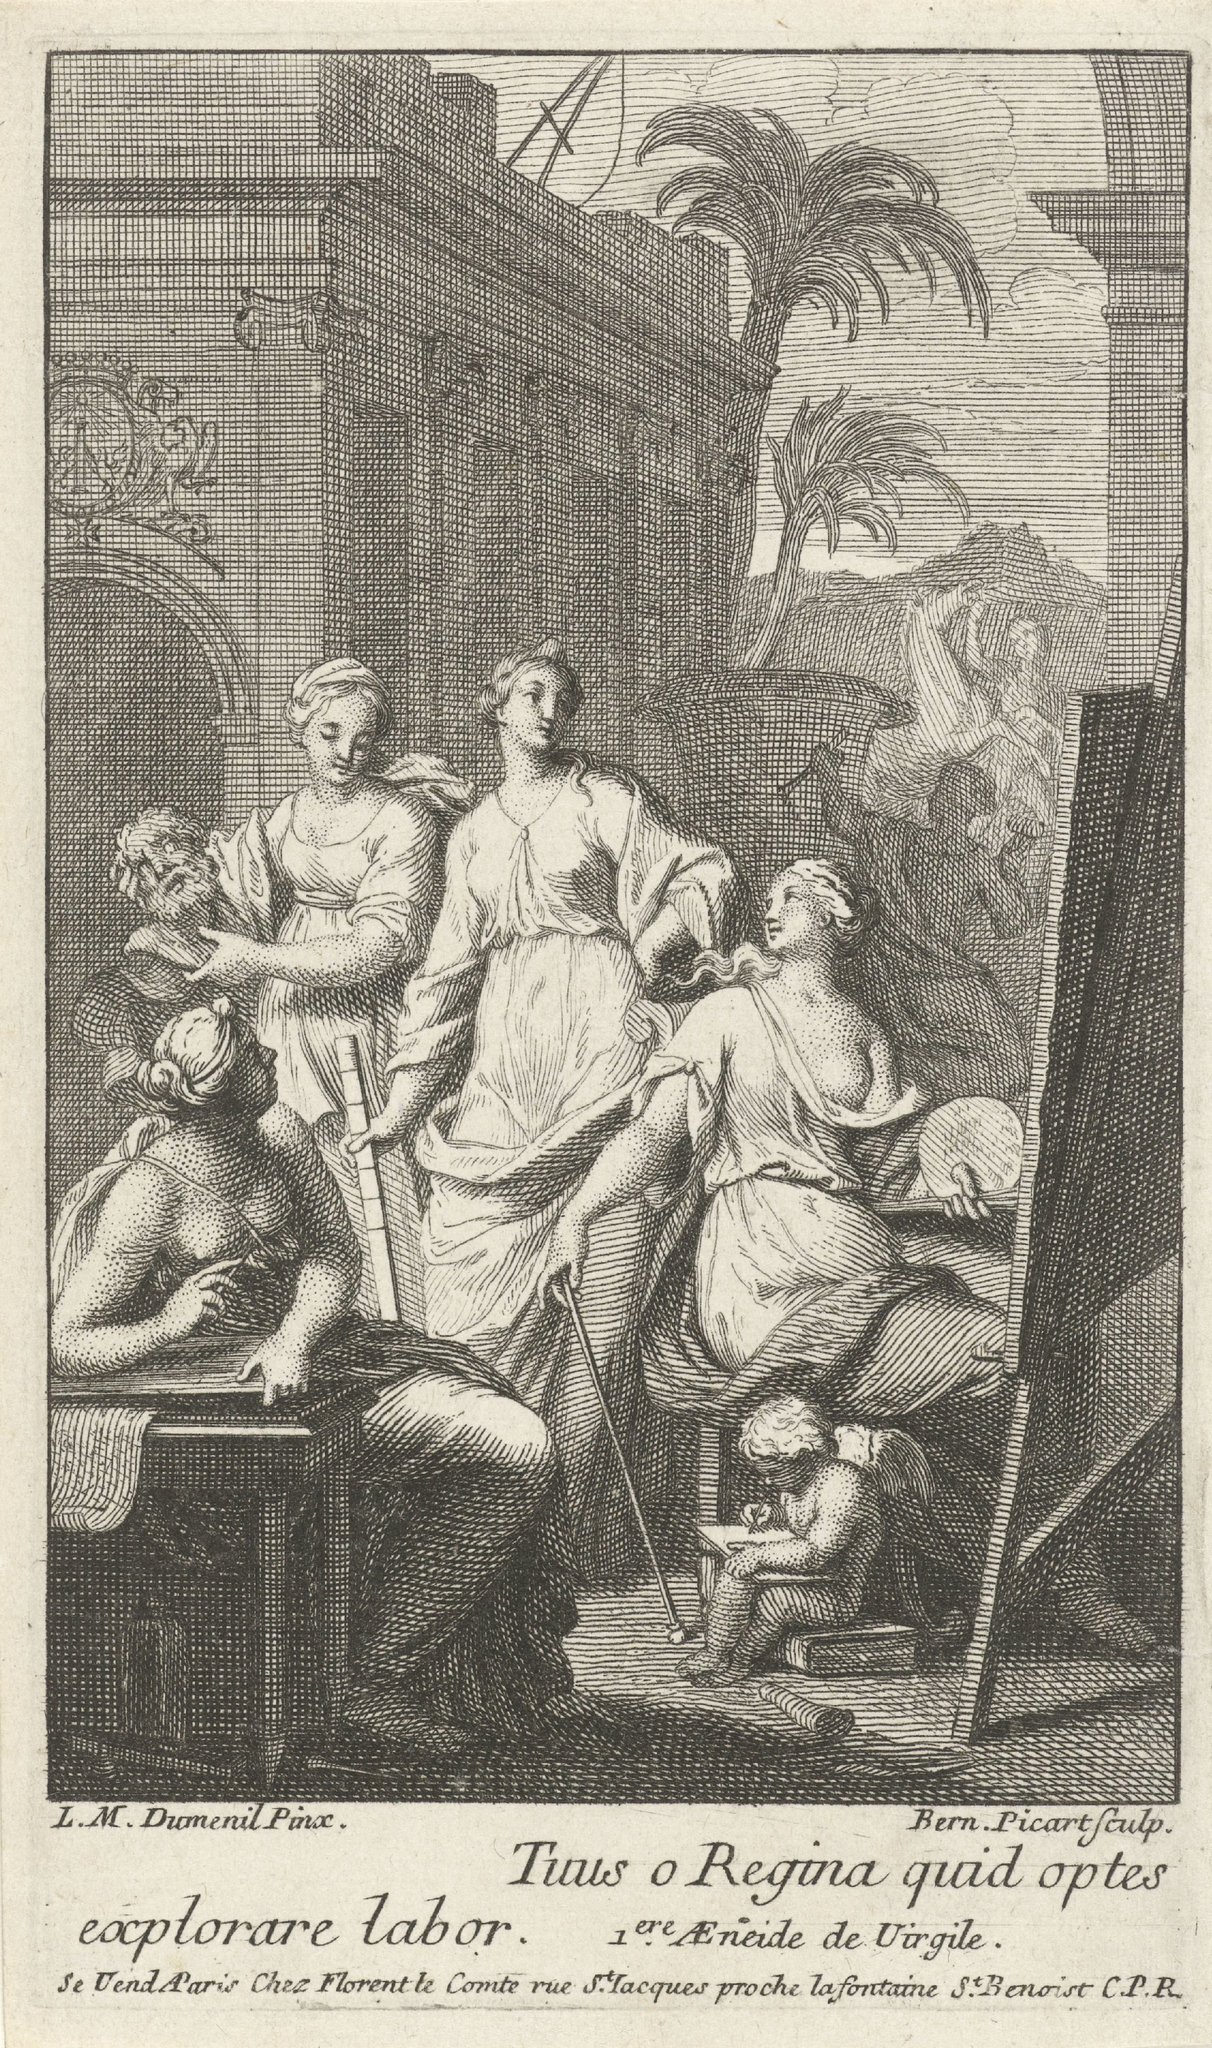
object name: print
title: Titelpagina voor: F. Le Comte, Cabinet des singularitez d'architecture, peinture, sculpture, et graveure, 1699-1700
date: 1699-1700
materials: paper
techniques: engraving, etching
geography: paris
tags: 'pictura', symbolic representations, allegories and emblems ~ painting; 'pittura' (ripa), 'sculptura', symbolic representations, allegories and emblems ~ sculpture; 'scoltura' (ripa), symbolic representations, allegories and emblems ~ the graphic arts, 'architectura', symbolic representations, allegories and emblems ~ architecture; 'architettura' (ripa)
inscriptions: collector's mark: Lugt 240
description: Schilderkunst zit voor een ezel en houdt een palet in de hand. Ze kijkt op naar Architectuur, die leunt op een liniaal, en Beeldhouwkunst, met een antieke buste in de hand. Op de voorgrond aan een tafel Graveerkunst met een burijn in de hand. In de marge een onderschrift uit de Aeneas van Virgilius in het Latijn.